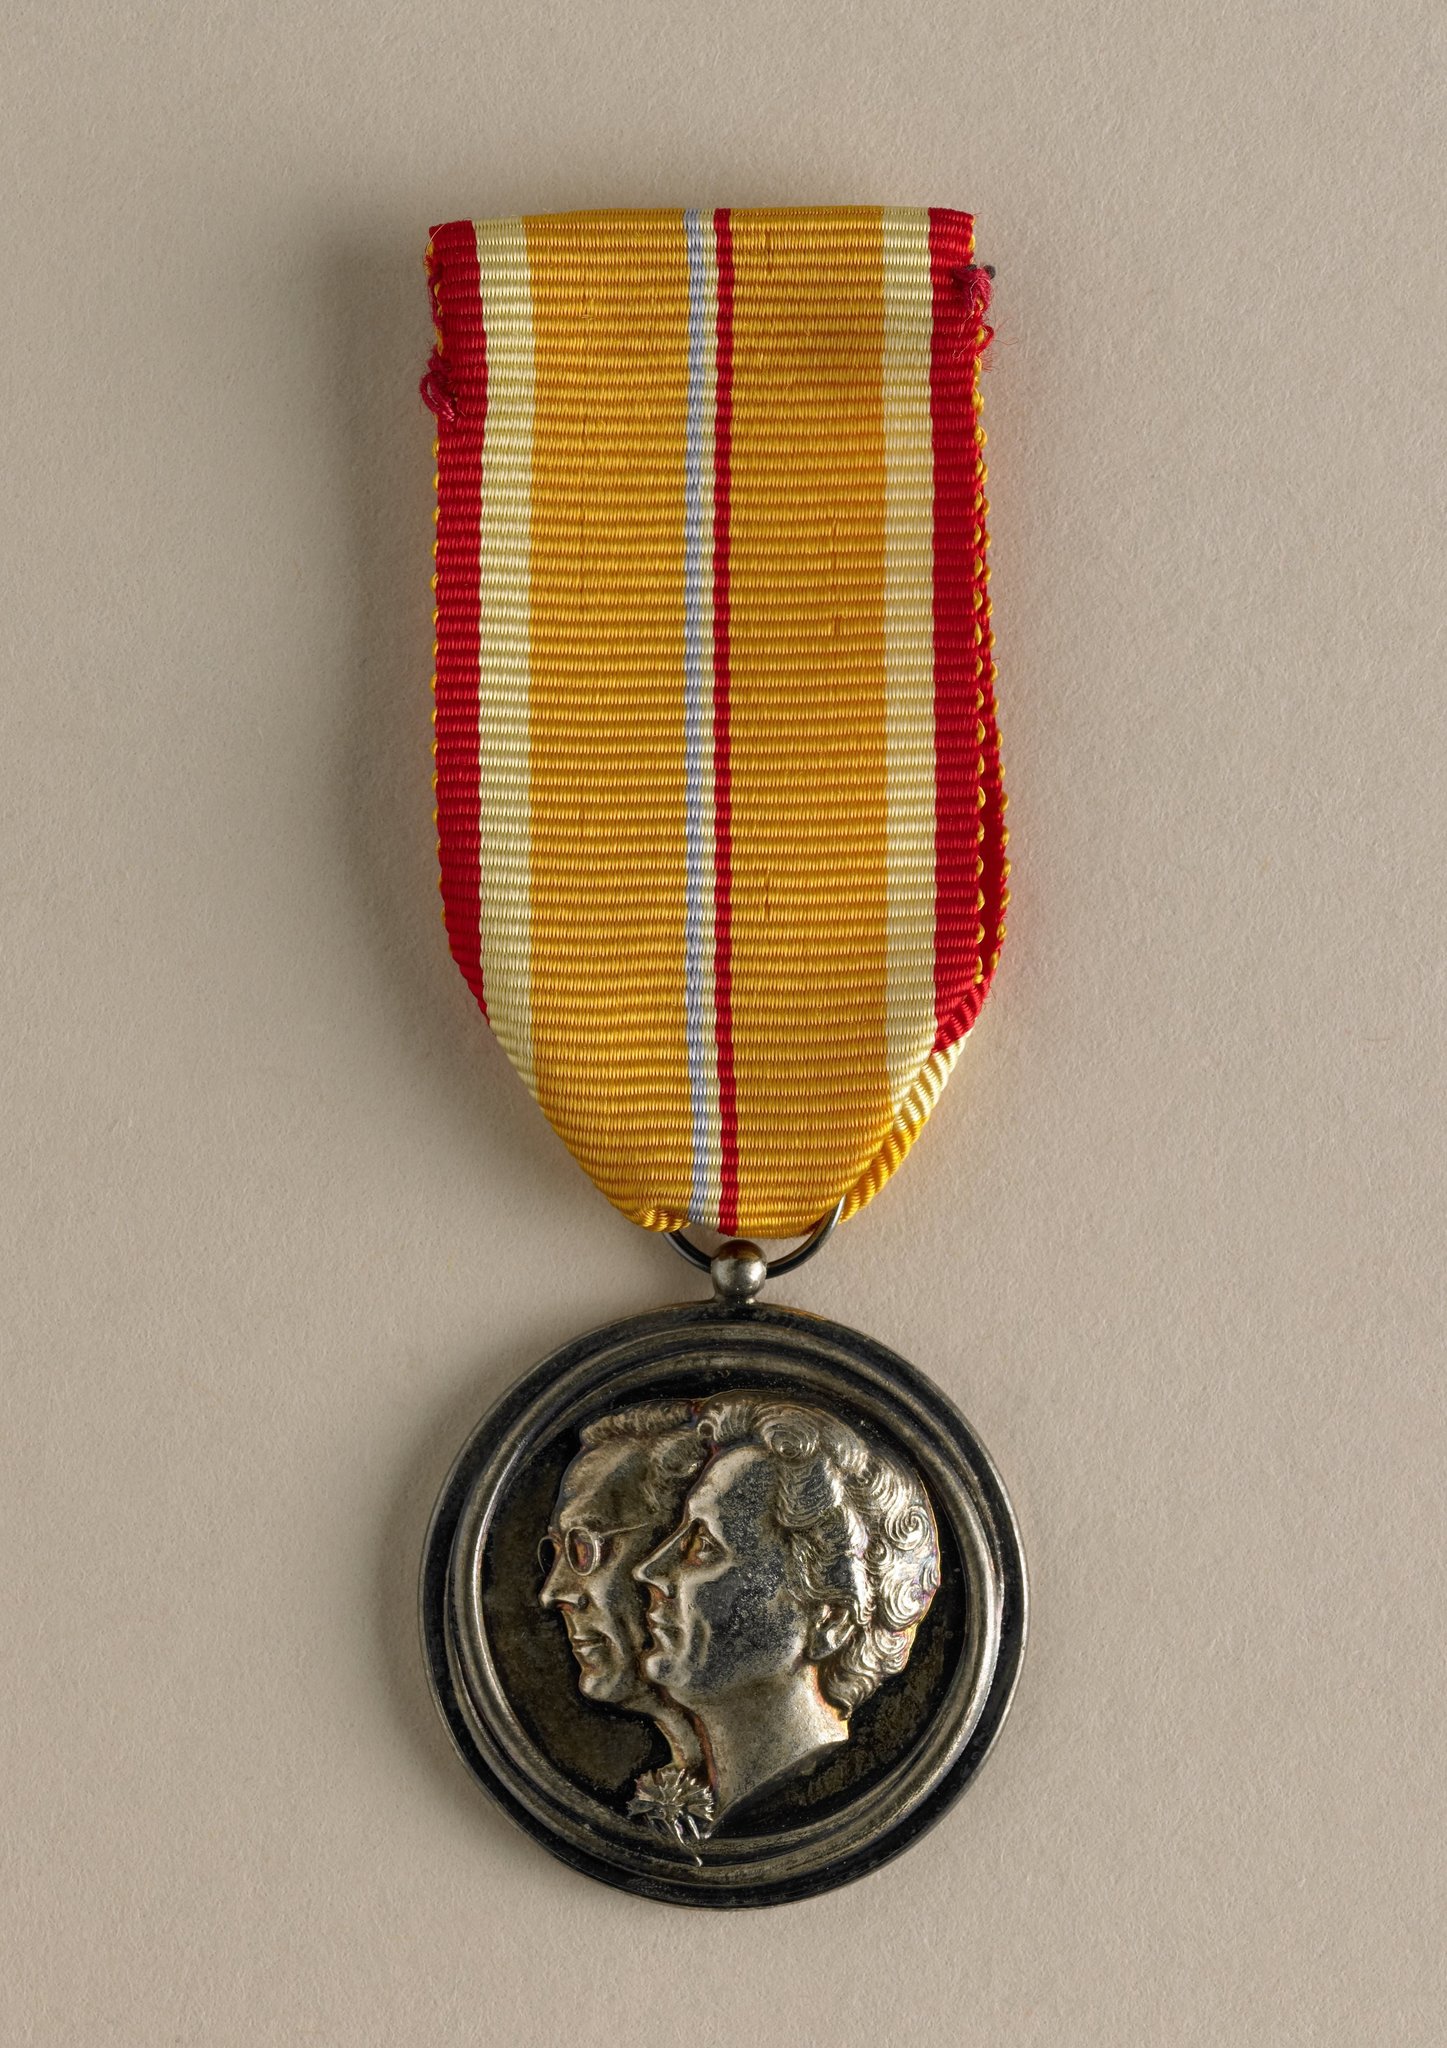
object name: draagpenning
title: Herinneringspenning bij het zilveren, vijfentwintigjarig huwelijk van koningin Juliana en prins Bernhard, 1962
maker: Anonymous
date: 1901-1962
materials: silver, textile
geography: netherlands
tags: utrecht, bernhard (prins der nederlanden), amsterdam, willem drees, the hague, juliana of the netherlands, netherlands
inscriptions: circumscription: ‘7 JANUARI 1937 1962’, inscription: ‘25 JB’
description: Zilveren penning aan draagring en oranje lint met rood-geel-blauwe strepen in het midden en geel-rode strepen aan de zijkanten, aan speld. Voorzijde: Juliana en Bernhard met anjer, met profiel naar links, binnen twee geschakelde ringen. Keerzijde: gekroonde 25 JB en aan de rand de datum 7 januari 1937 - 1962. Bijbehorend een wit doosje met aan de binnenkant blauw fluweel.